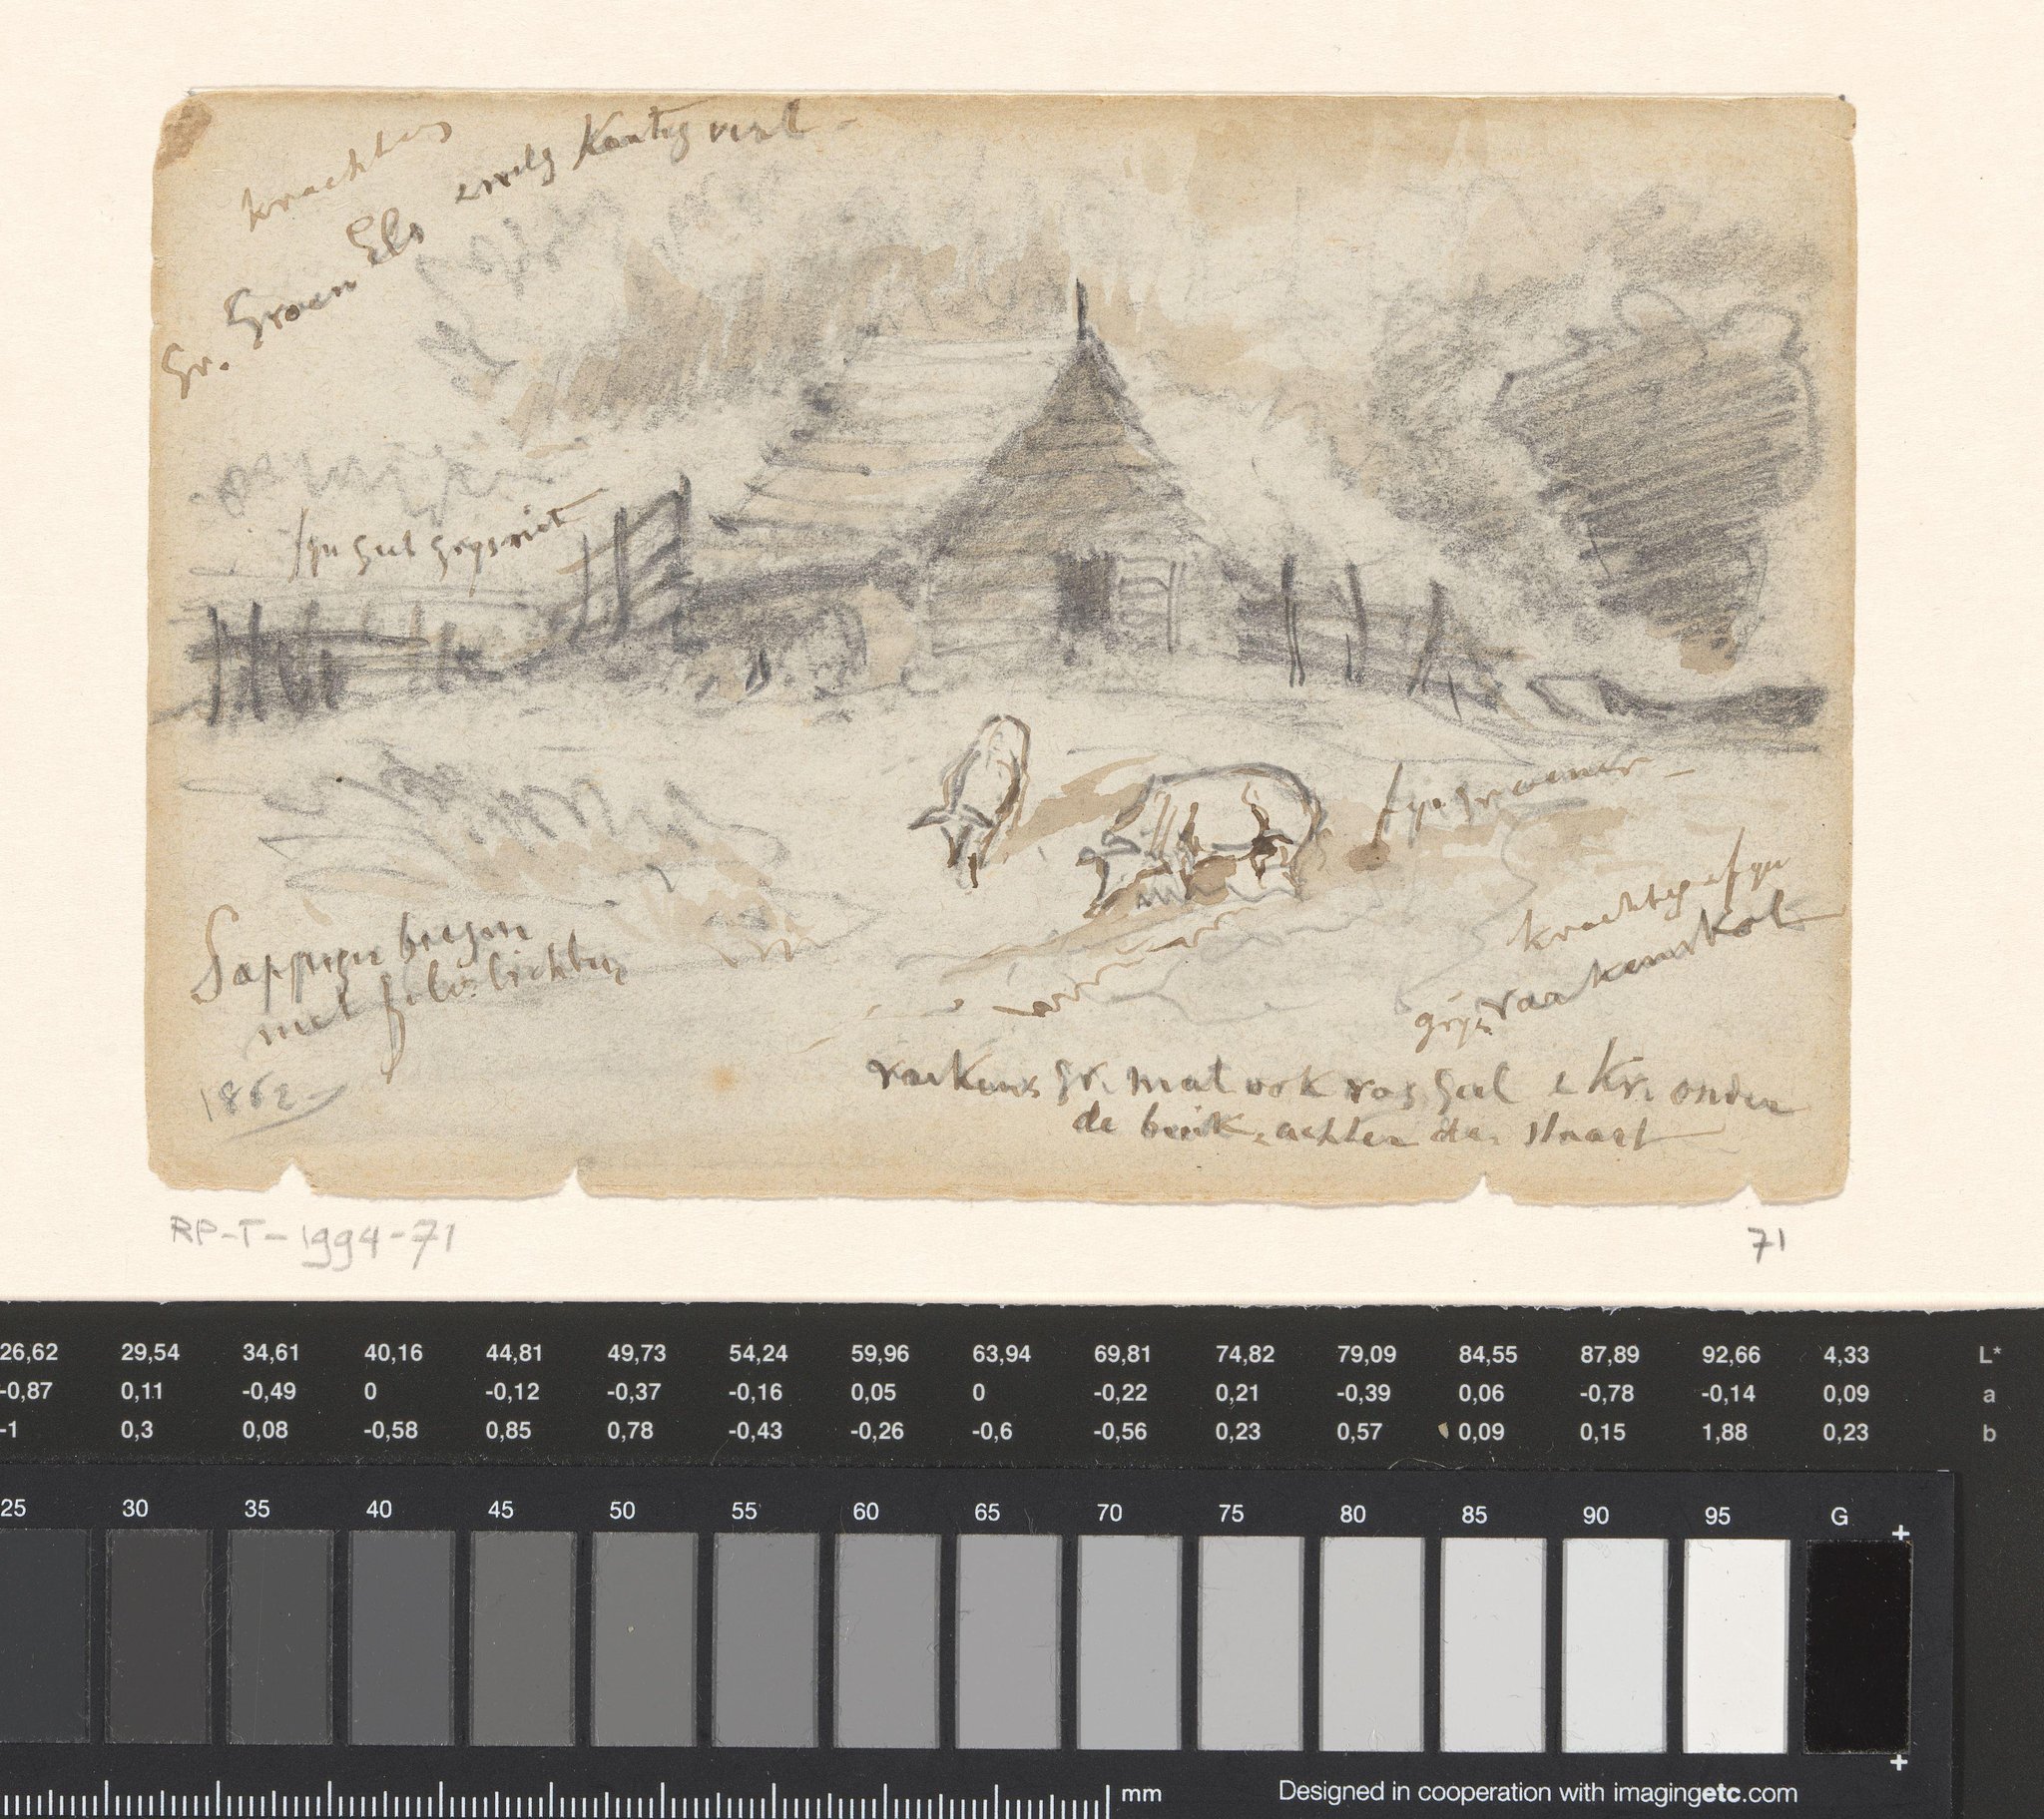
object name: drawing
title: Varkens bij een boerenschuur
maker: johannes tavenraat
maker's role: draughtsman, painter, print maker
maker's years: 1809-1881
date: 1862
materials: ink, paper, pencil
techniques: brush, pen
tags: pig, farm (building)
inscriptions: annotation, date: ‘62’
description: Schetsboekblad met varkens bij een boerenschuur en meerdere aantekeningen.